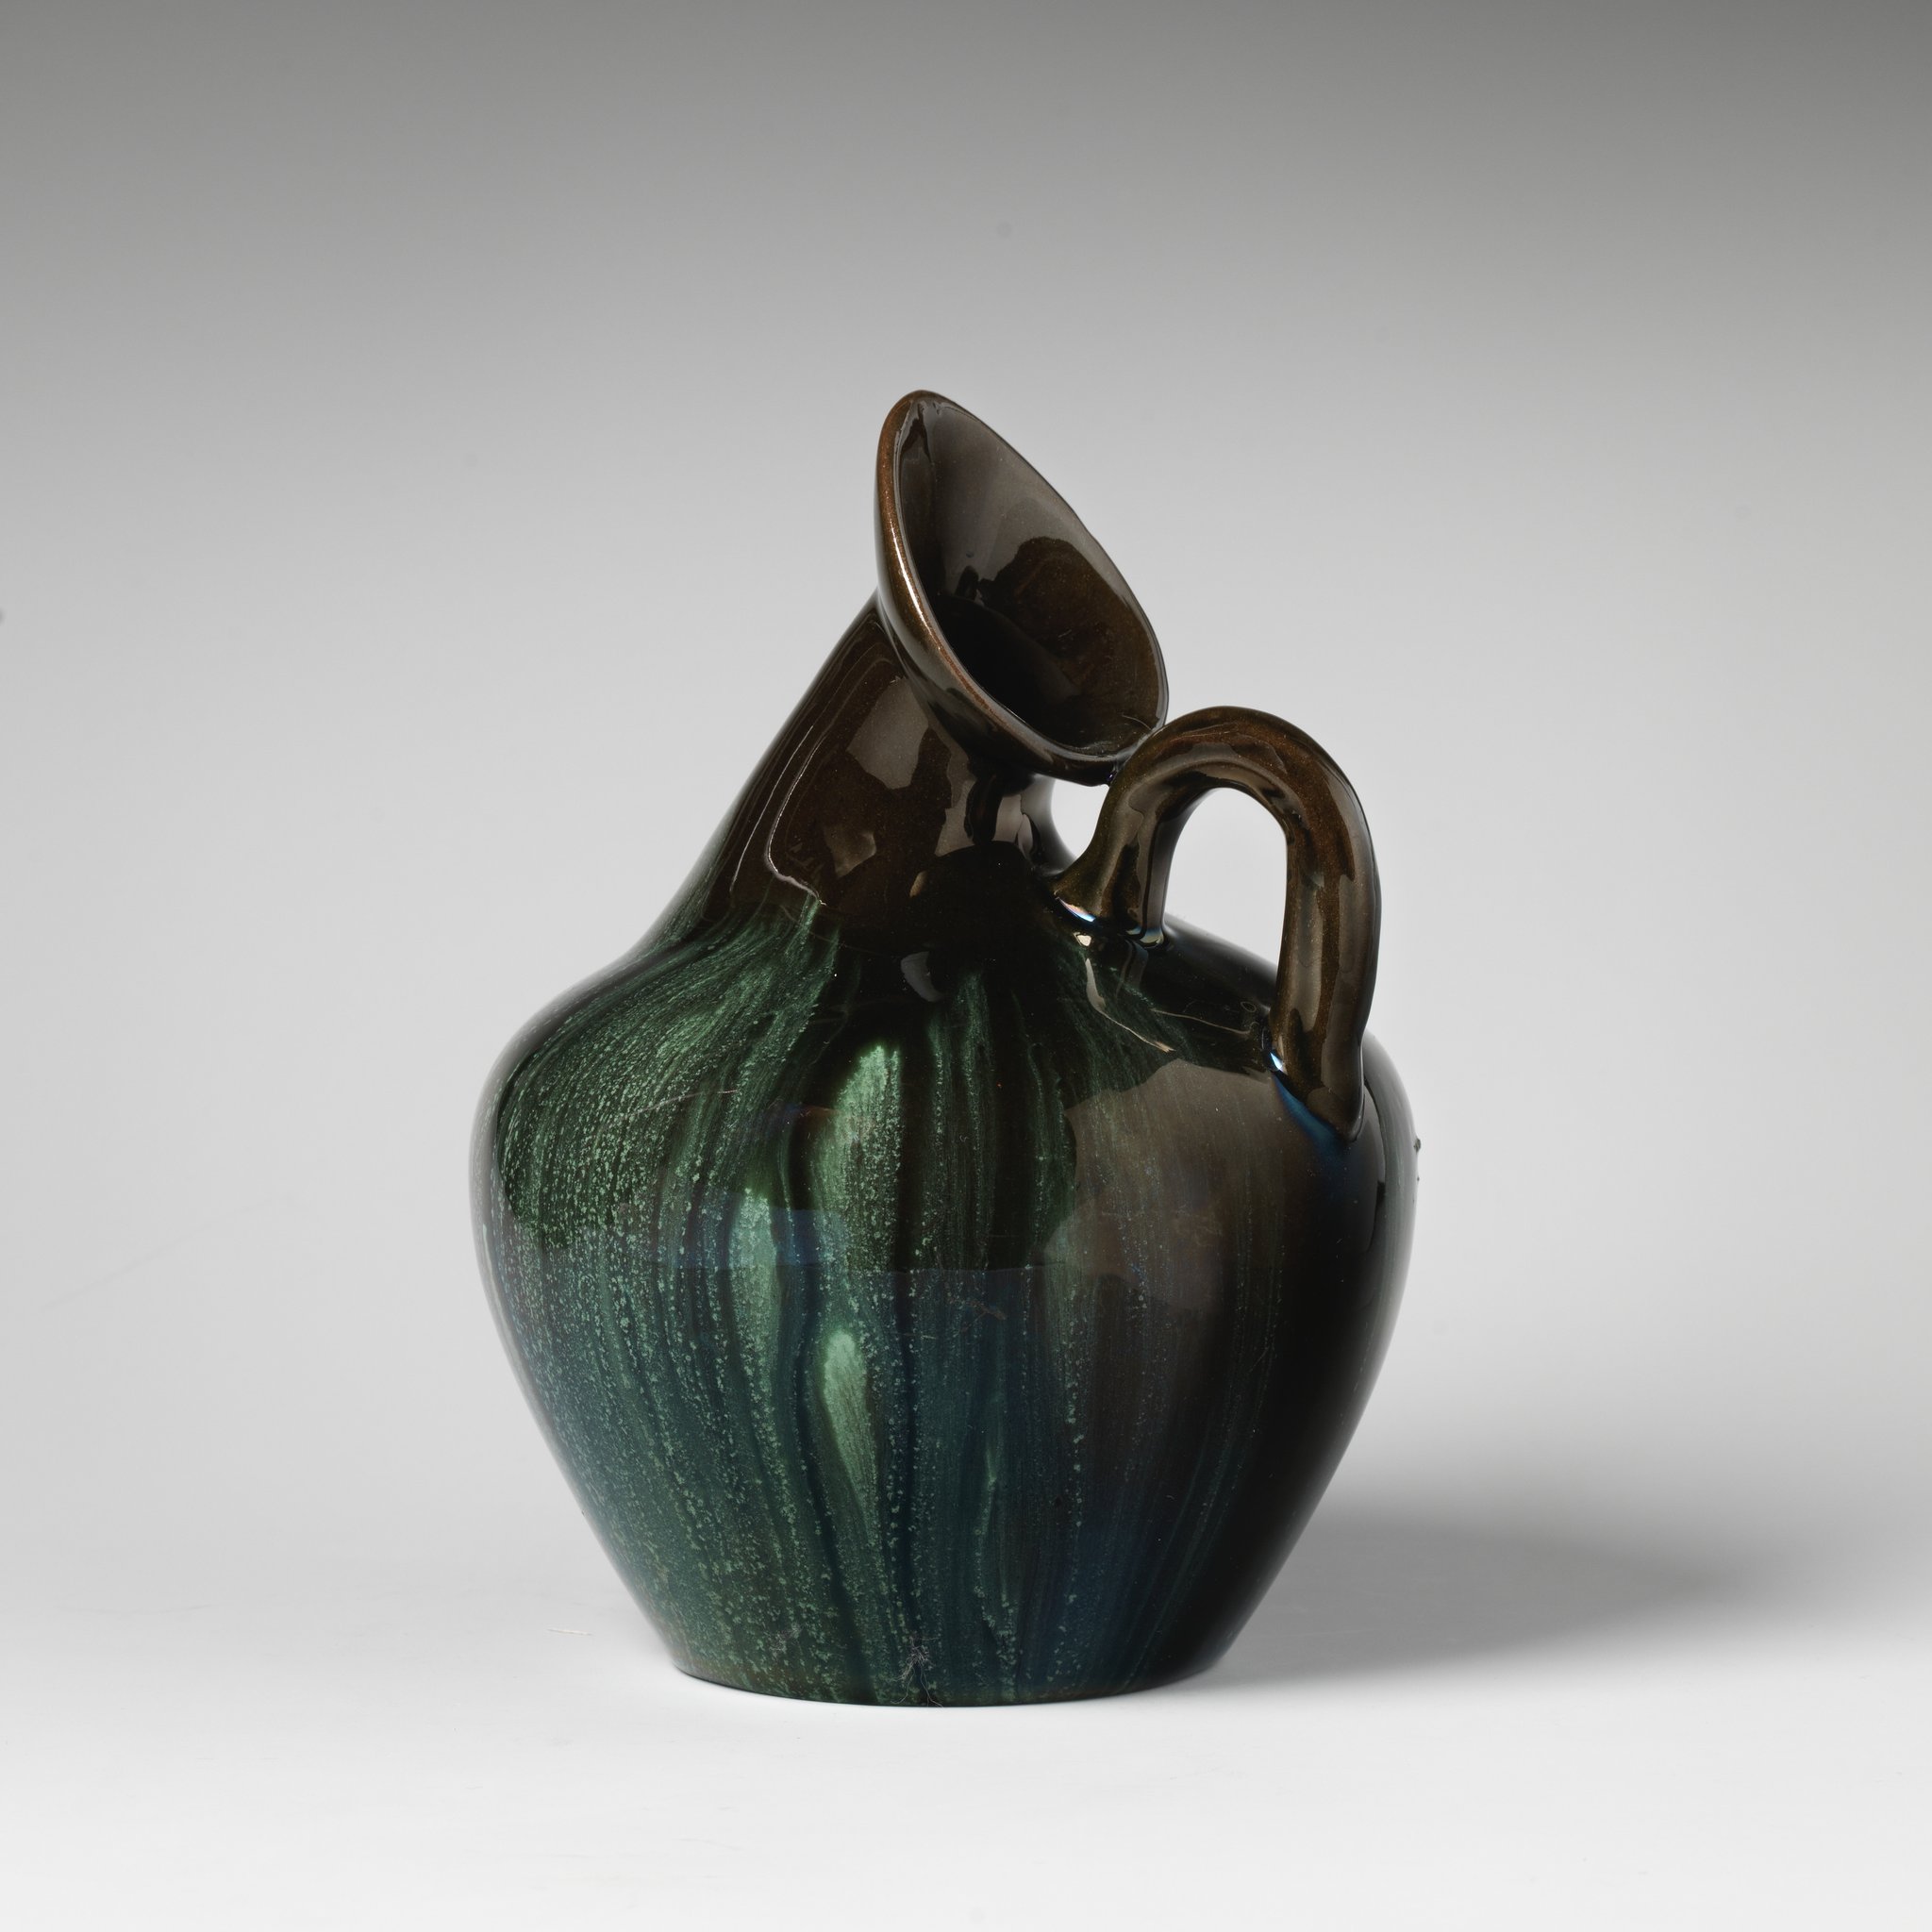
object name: pitcher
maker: linthorpe pottery works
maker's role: factory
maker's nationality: british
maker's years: 1879-1889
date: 1879-1882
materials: earthenware